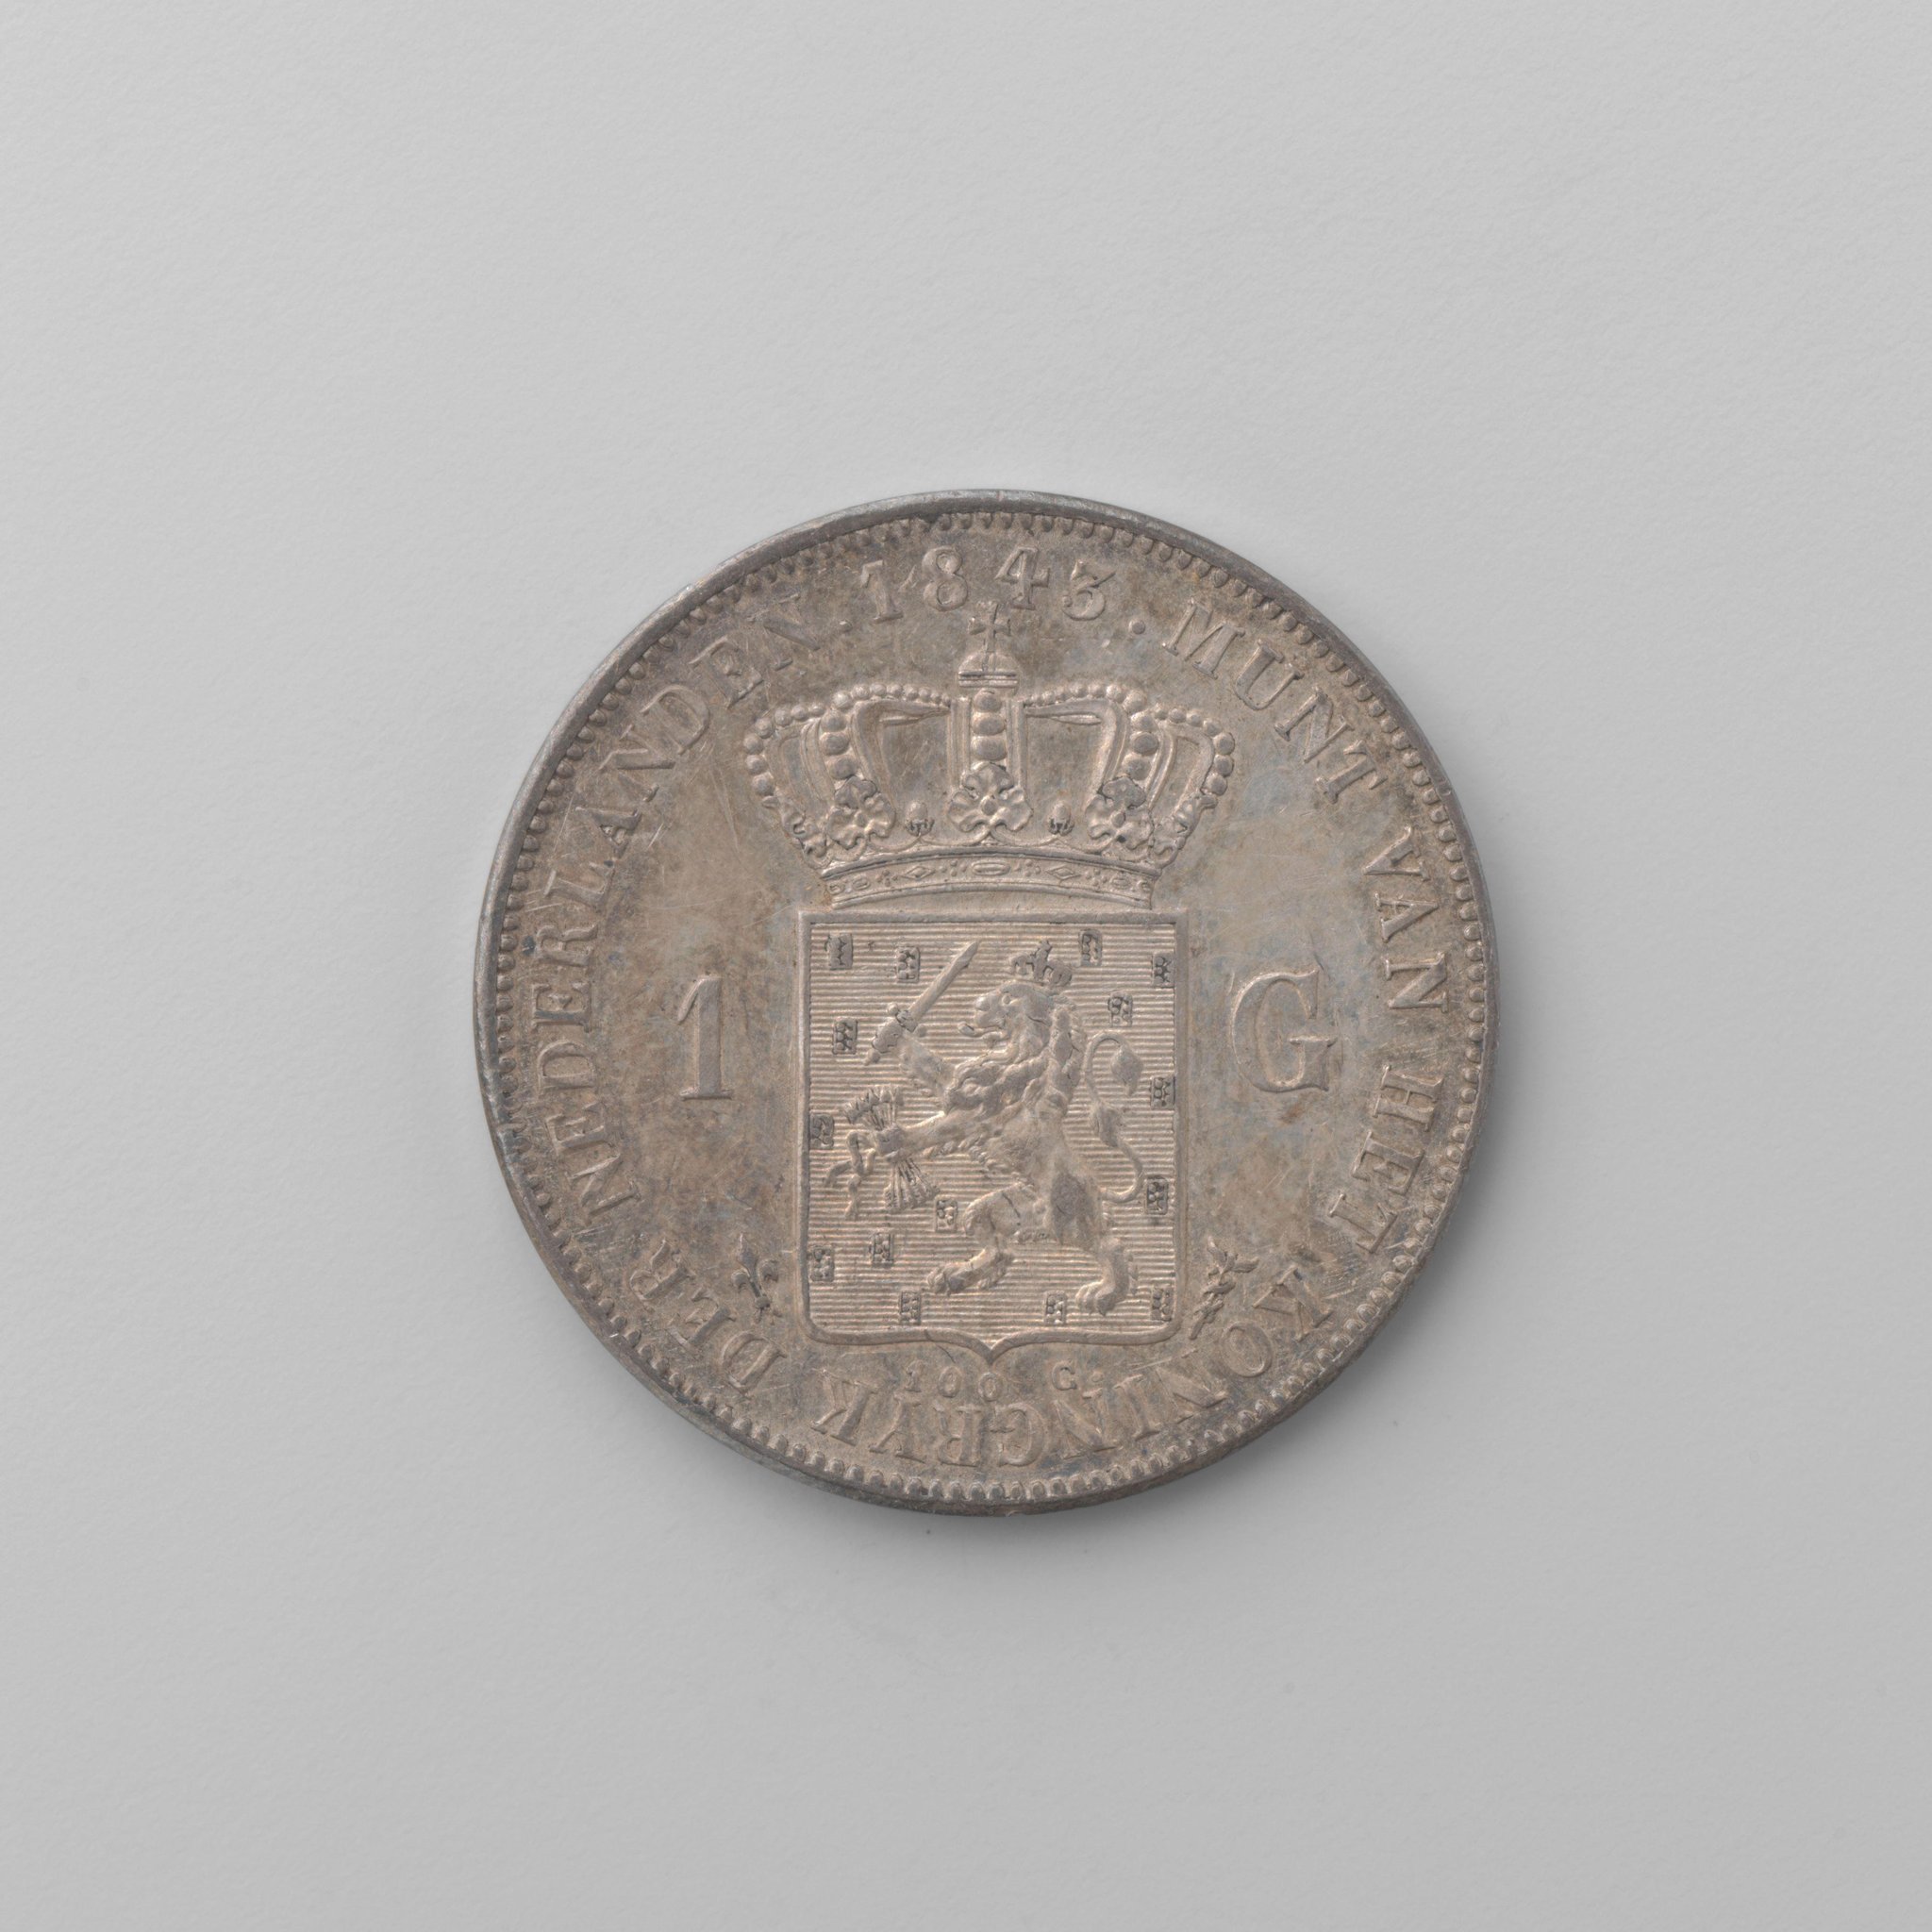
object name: coin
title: Nederland, gulden, 1843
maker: william ii of the netherlands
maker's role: koning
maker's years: 1792-1849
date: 1843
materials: silver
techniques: striking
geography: utrecht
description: Zilveren munt. Voorzijde: borstbeeld naar links. Keerzijde: tussen waarde-aanduiding 1 G gekroond rijkswapenschild. Jaartal boven kroon. Randschrift.